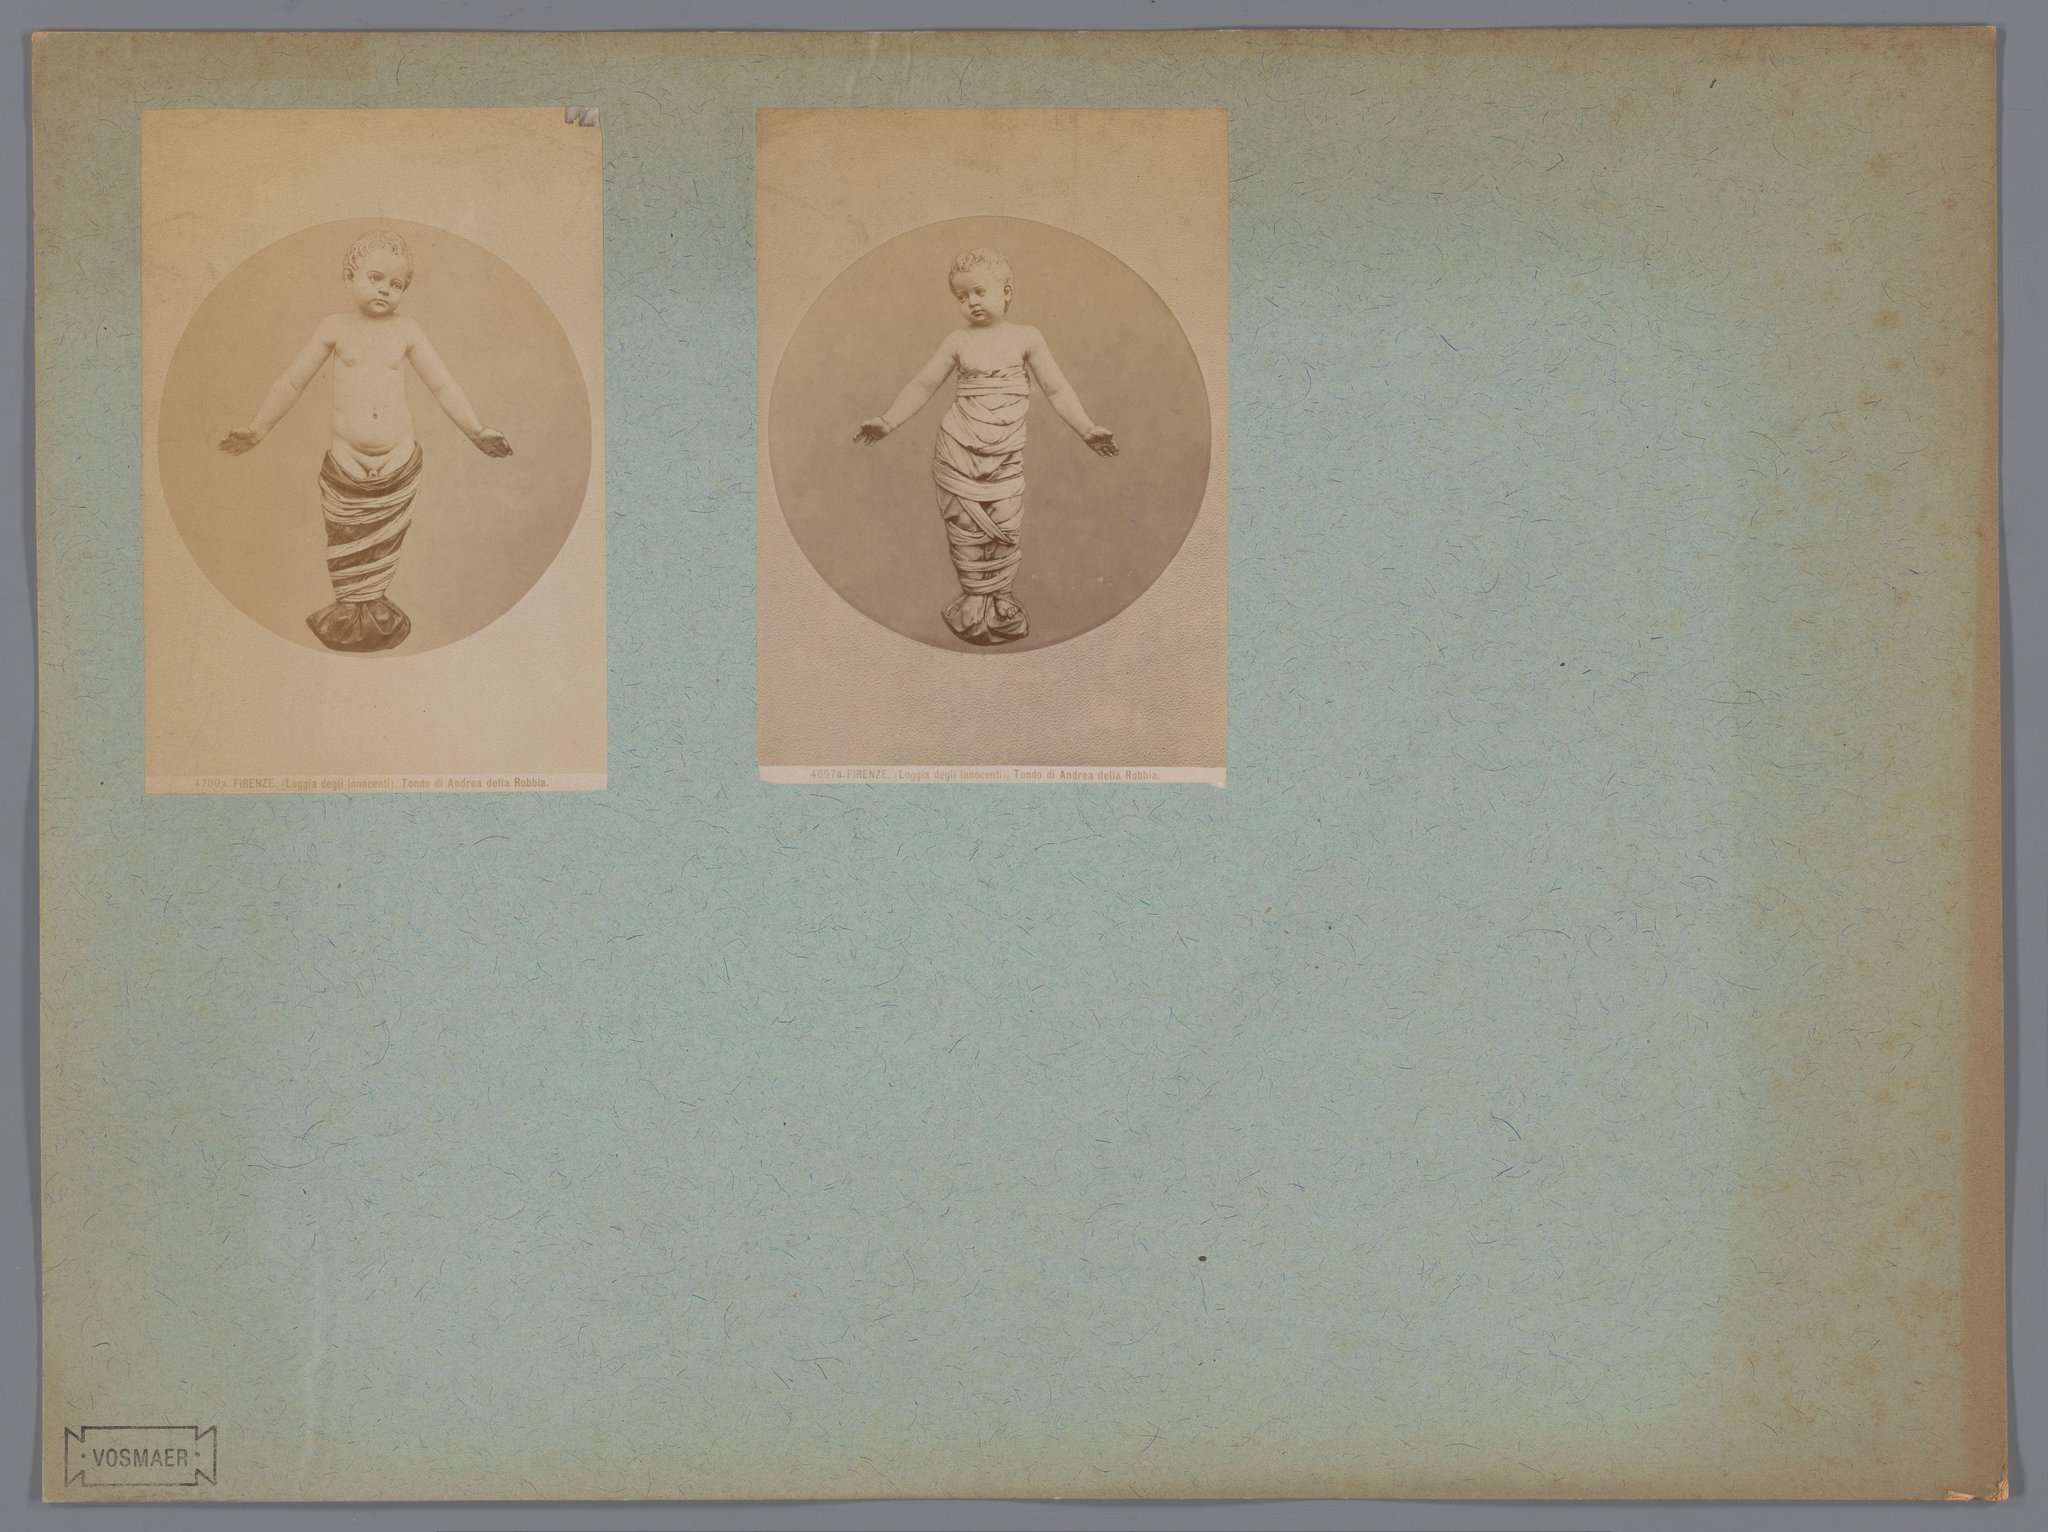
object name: photograph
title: Firenze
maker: giacomo brogi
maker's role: fotograaf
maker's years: 1822-1881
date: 1856-1881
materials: cardboard, paper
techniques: albumen print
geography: florence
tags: picture, painting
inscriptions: number: ‘4697a.’, retailer's mark: ‘VOSMAER’